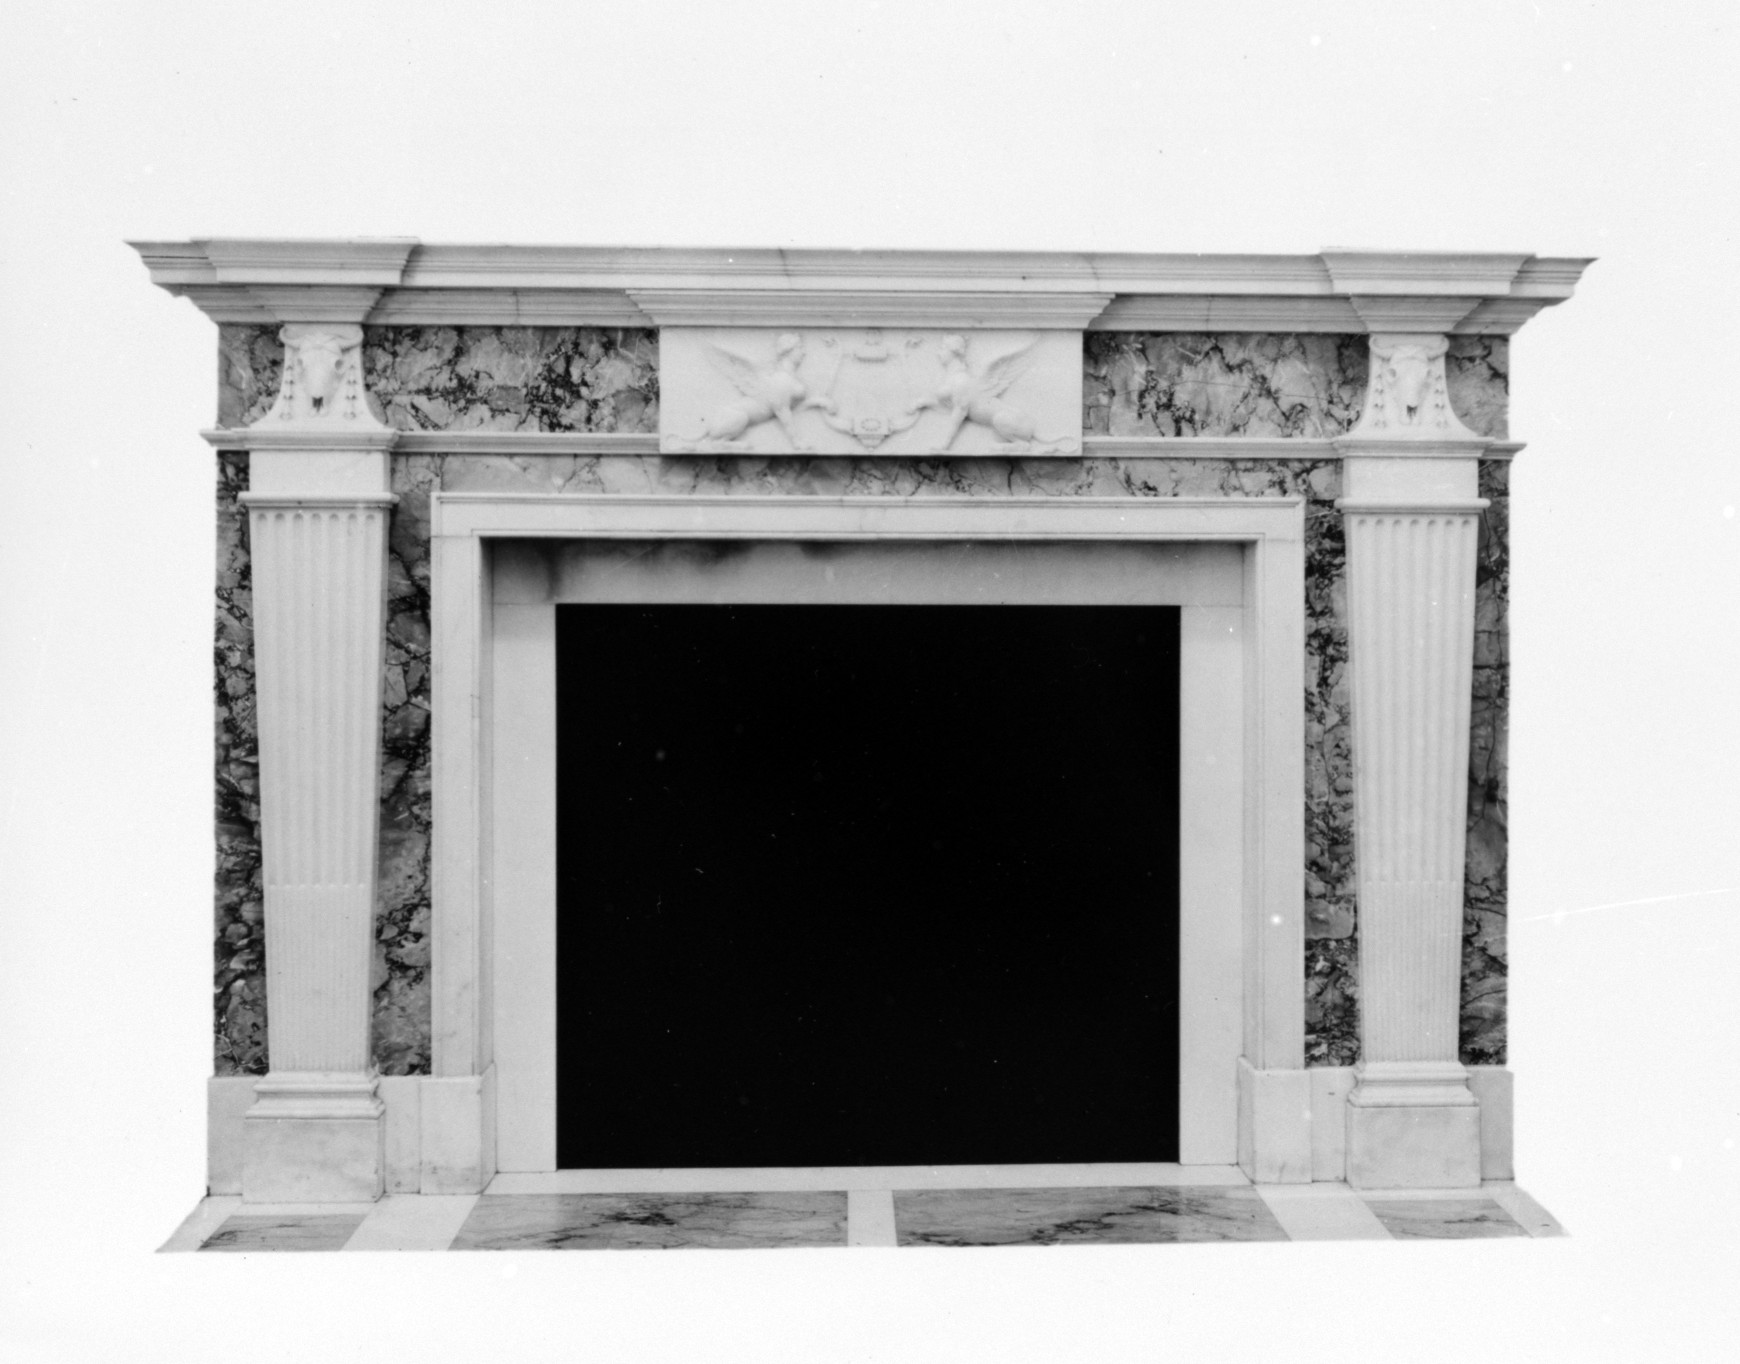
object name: mantel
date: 1770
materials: marble